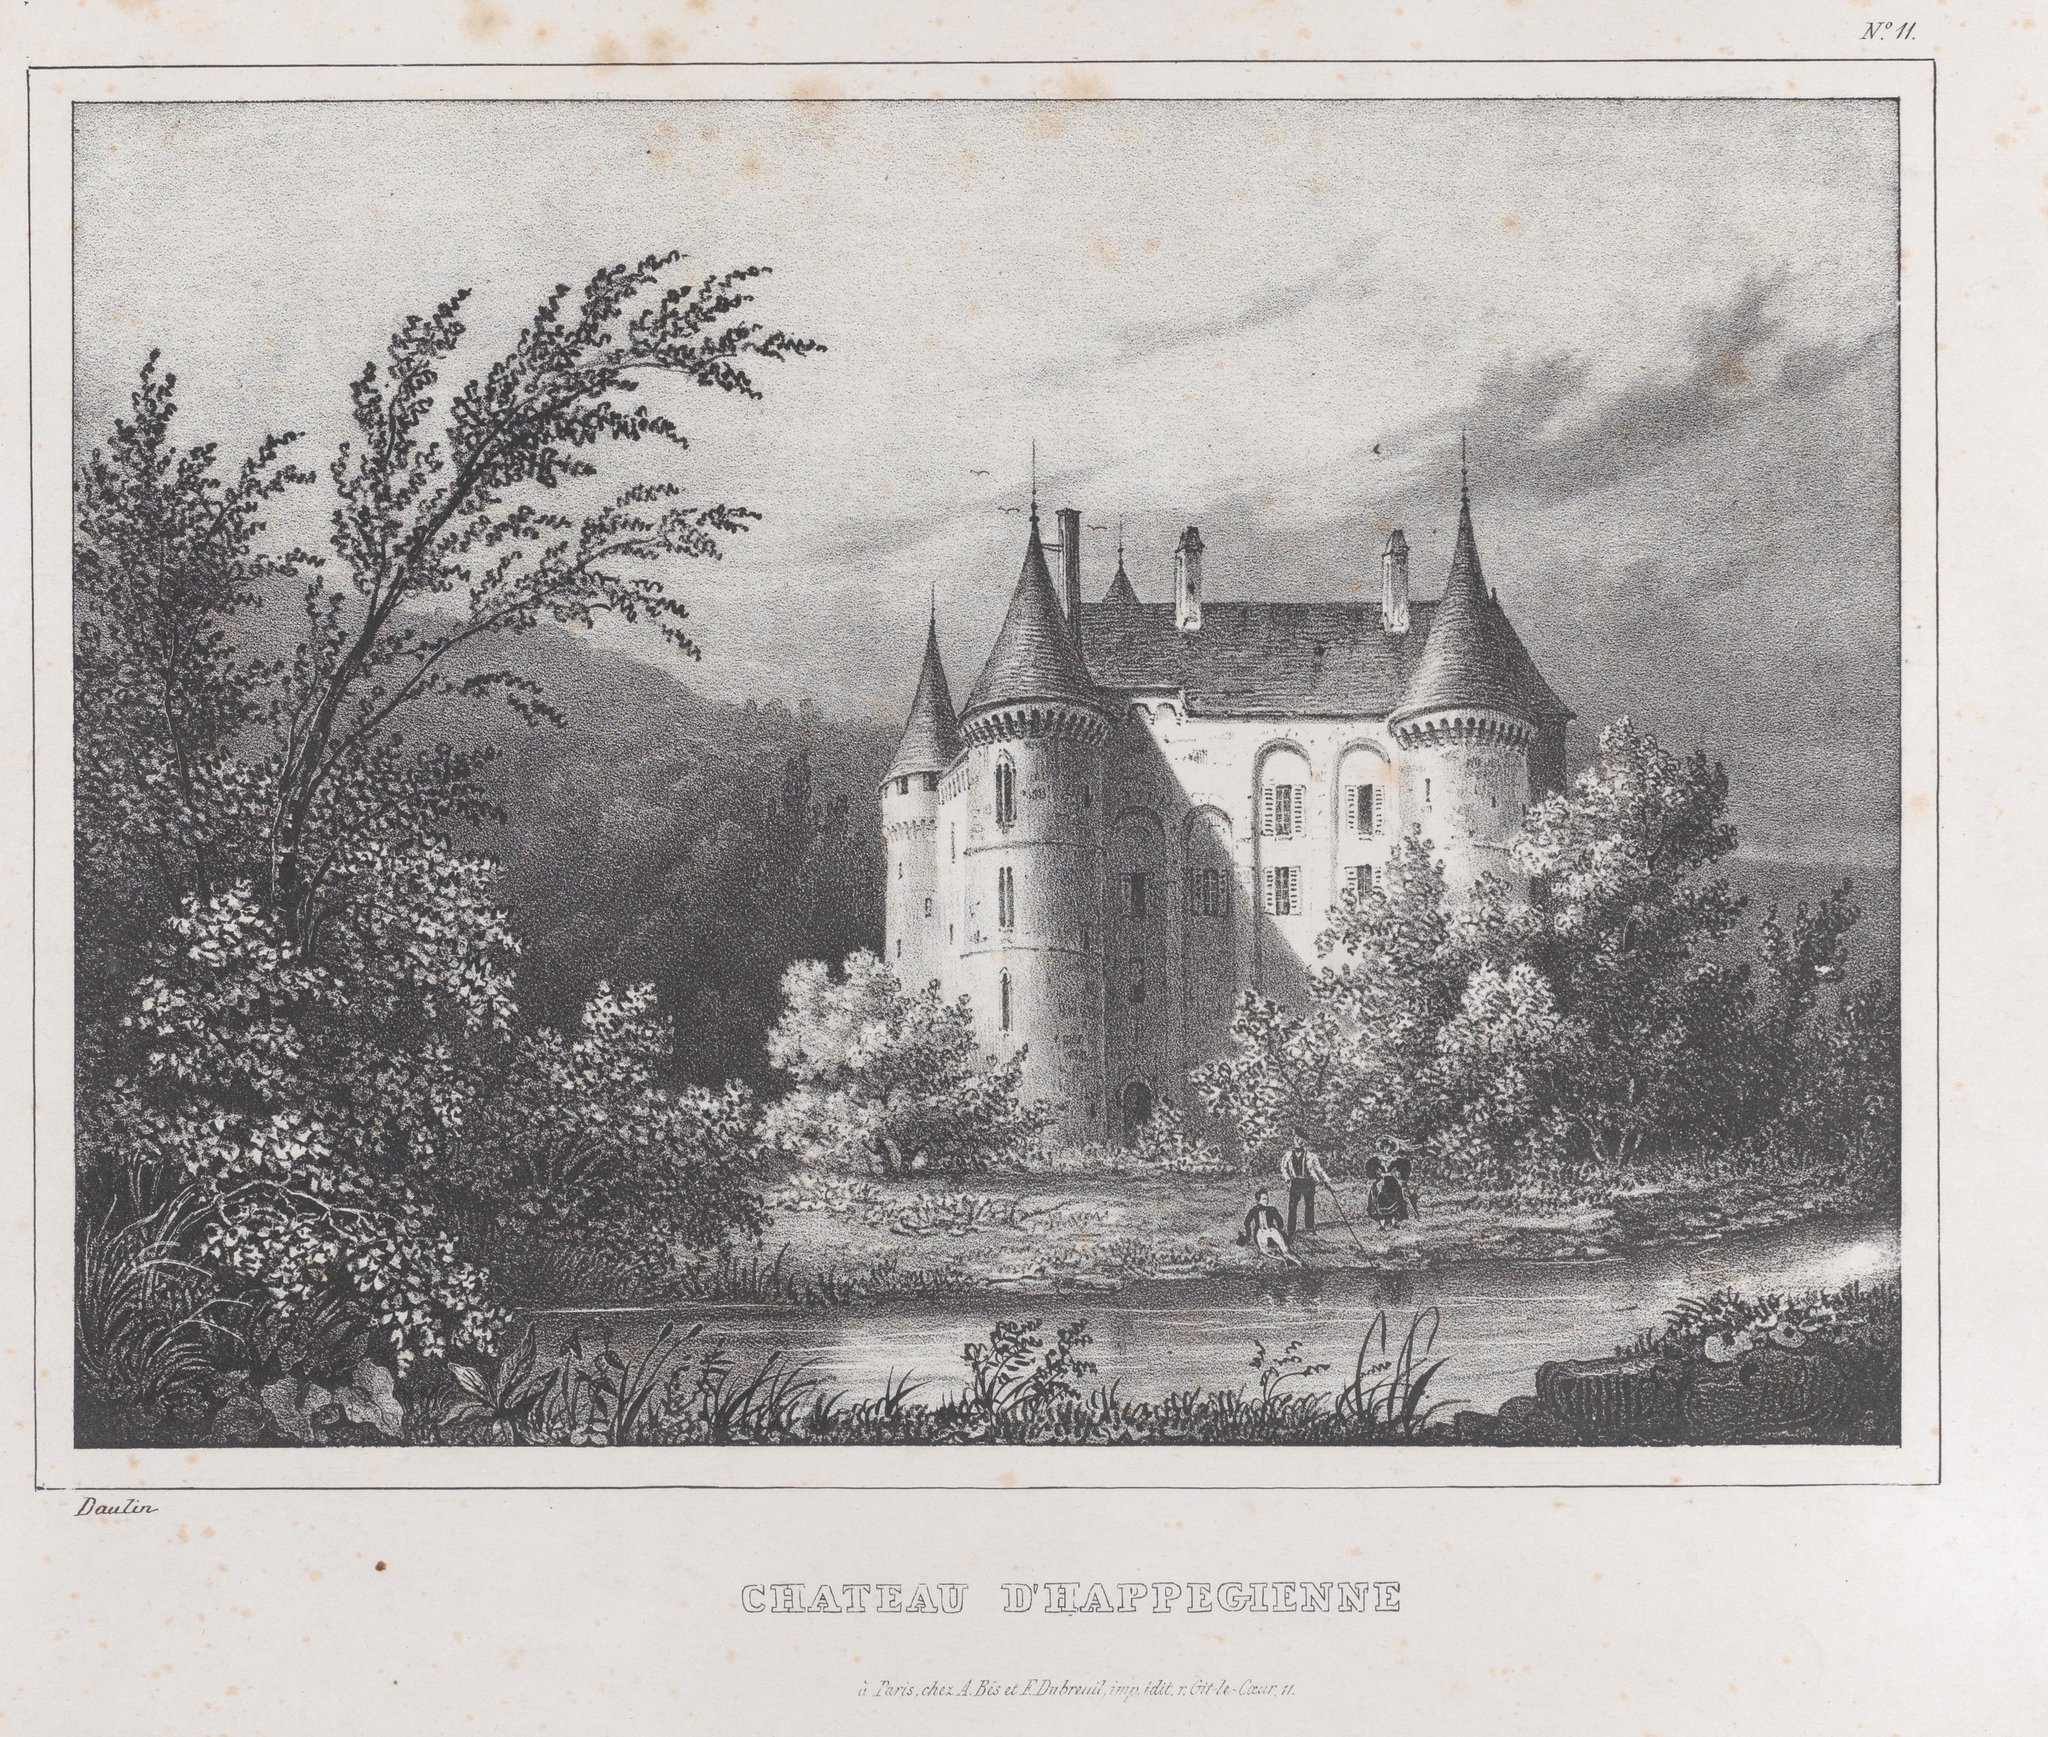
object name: print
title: Château d'Happegienne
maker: Anonymous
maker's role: artist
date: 1830-1860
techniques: lithograph